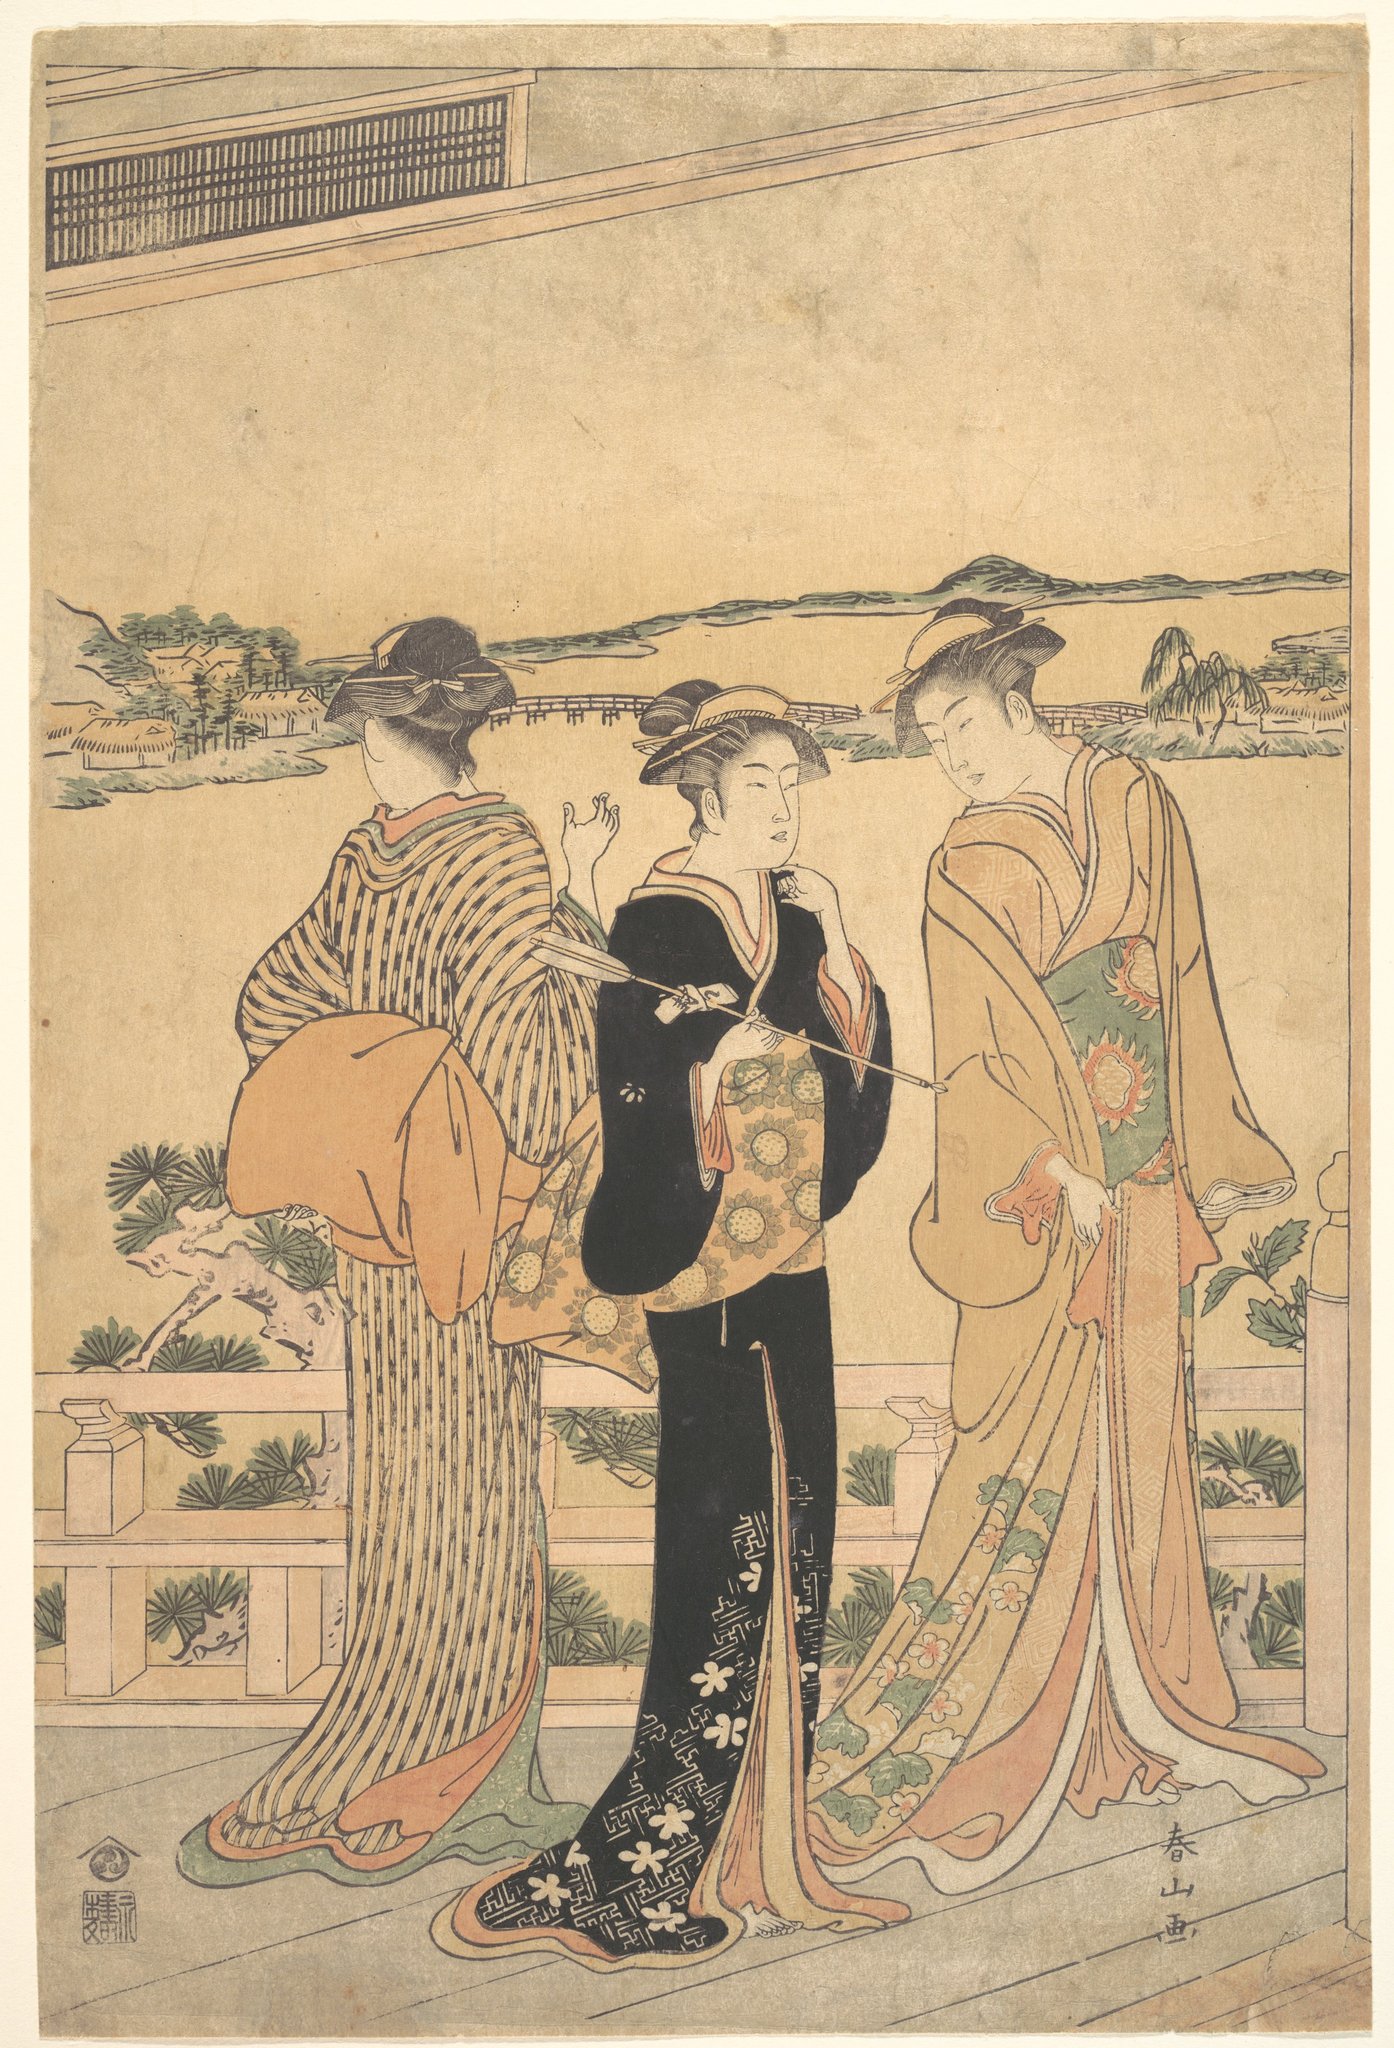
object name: print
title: Three Women on a Veranda Overlooking a Bay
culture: japanese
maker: katsukawa shunzan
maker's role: artist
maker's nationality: japanese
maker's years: 1782-1798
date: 1782-1798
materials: ink, paper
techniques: woodblock print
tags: arrows,women